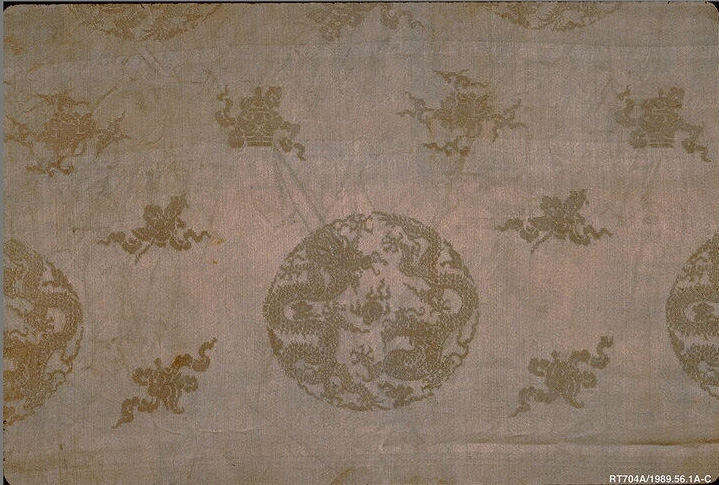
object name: breadth of woven textile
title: Breadth of WovenTextile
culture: chinese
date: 1701-1733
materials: gold, textile, silk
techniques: brocade, damask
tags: dragons